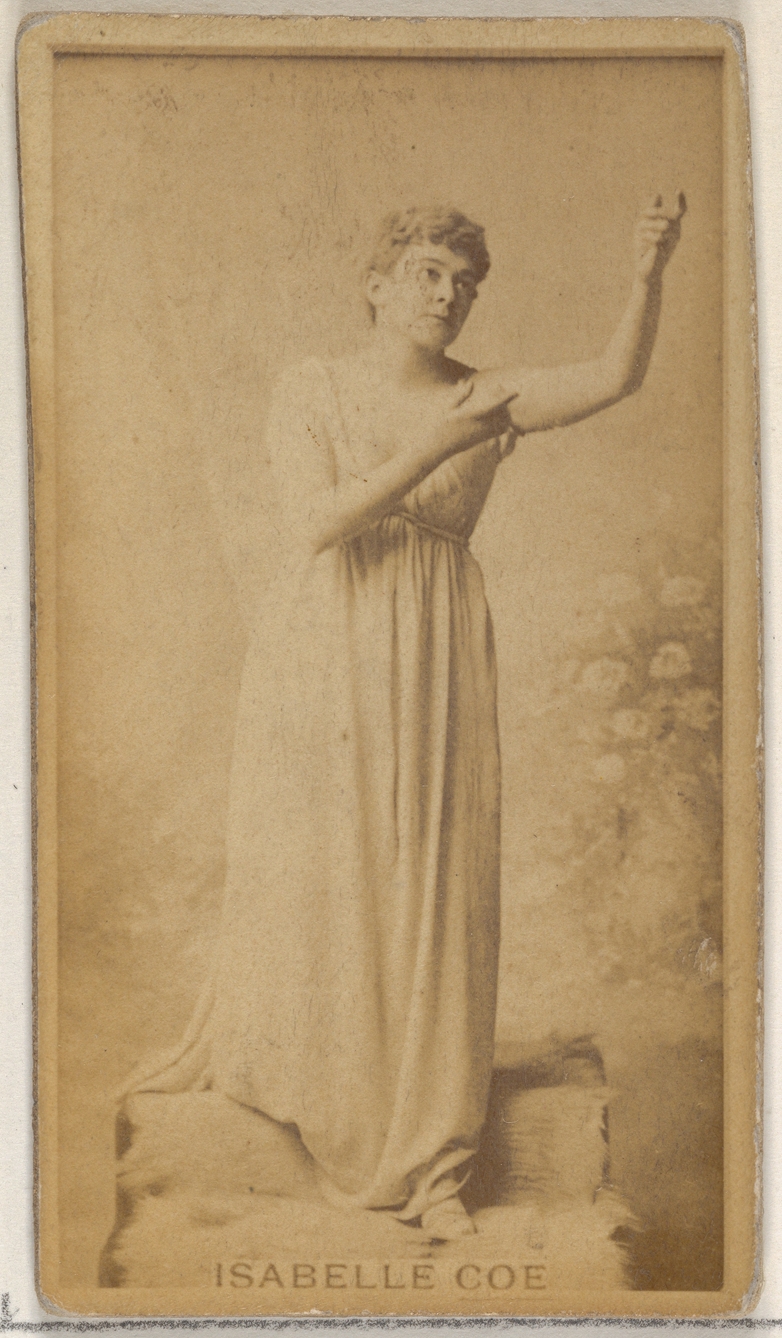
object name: photograph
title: Isabelle Coe, from the Actors and Actresses series (N45, Type 8) for Virginia Brights Cigarettes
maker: allen & ginter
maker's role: publisher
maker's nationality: american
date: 1888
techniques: albumen silver print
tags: portraits,women,actresses